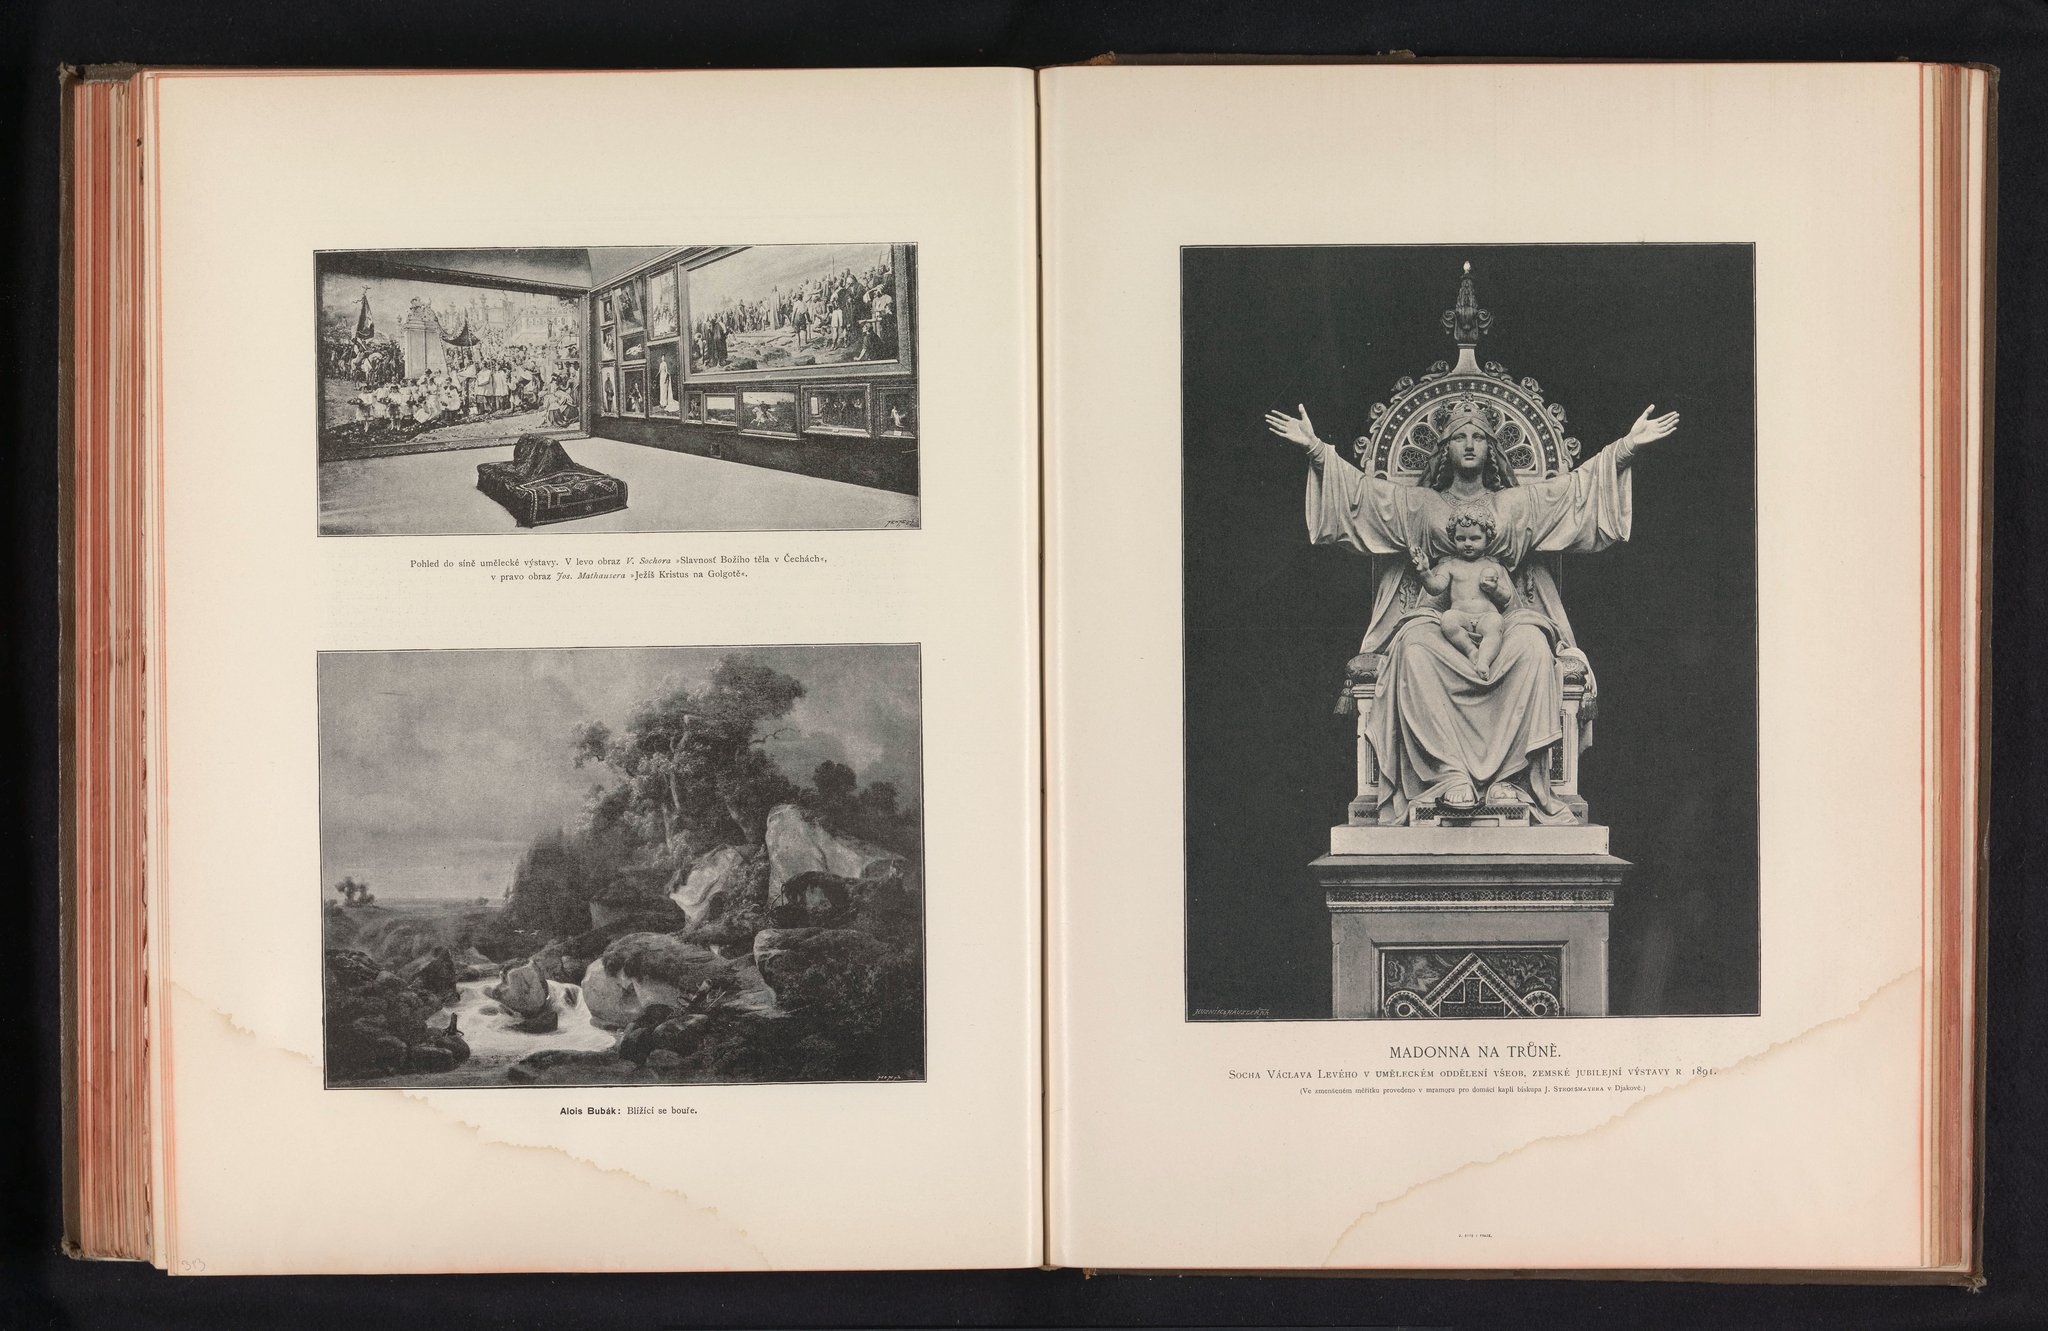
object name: page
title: Interieur van een schilderijententoonstelling en een fotoreproductie van een schilderij, voorstellende een rotslandschap tijdens een storm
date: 1891-1895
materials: paper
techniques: autotype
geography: prague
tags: landscapes, collection, exhibition, show, storm on land